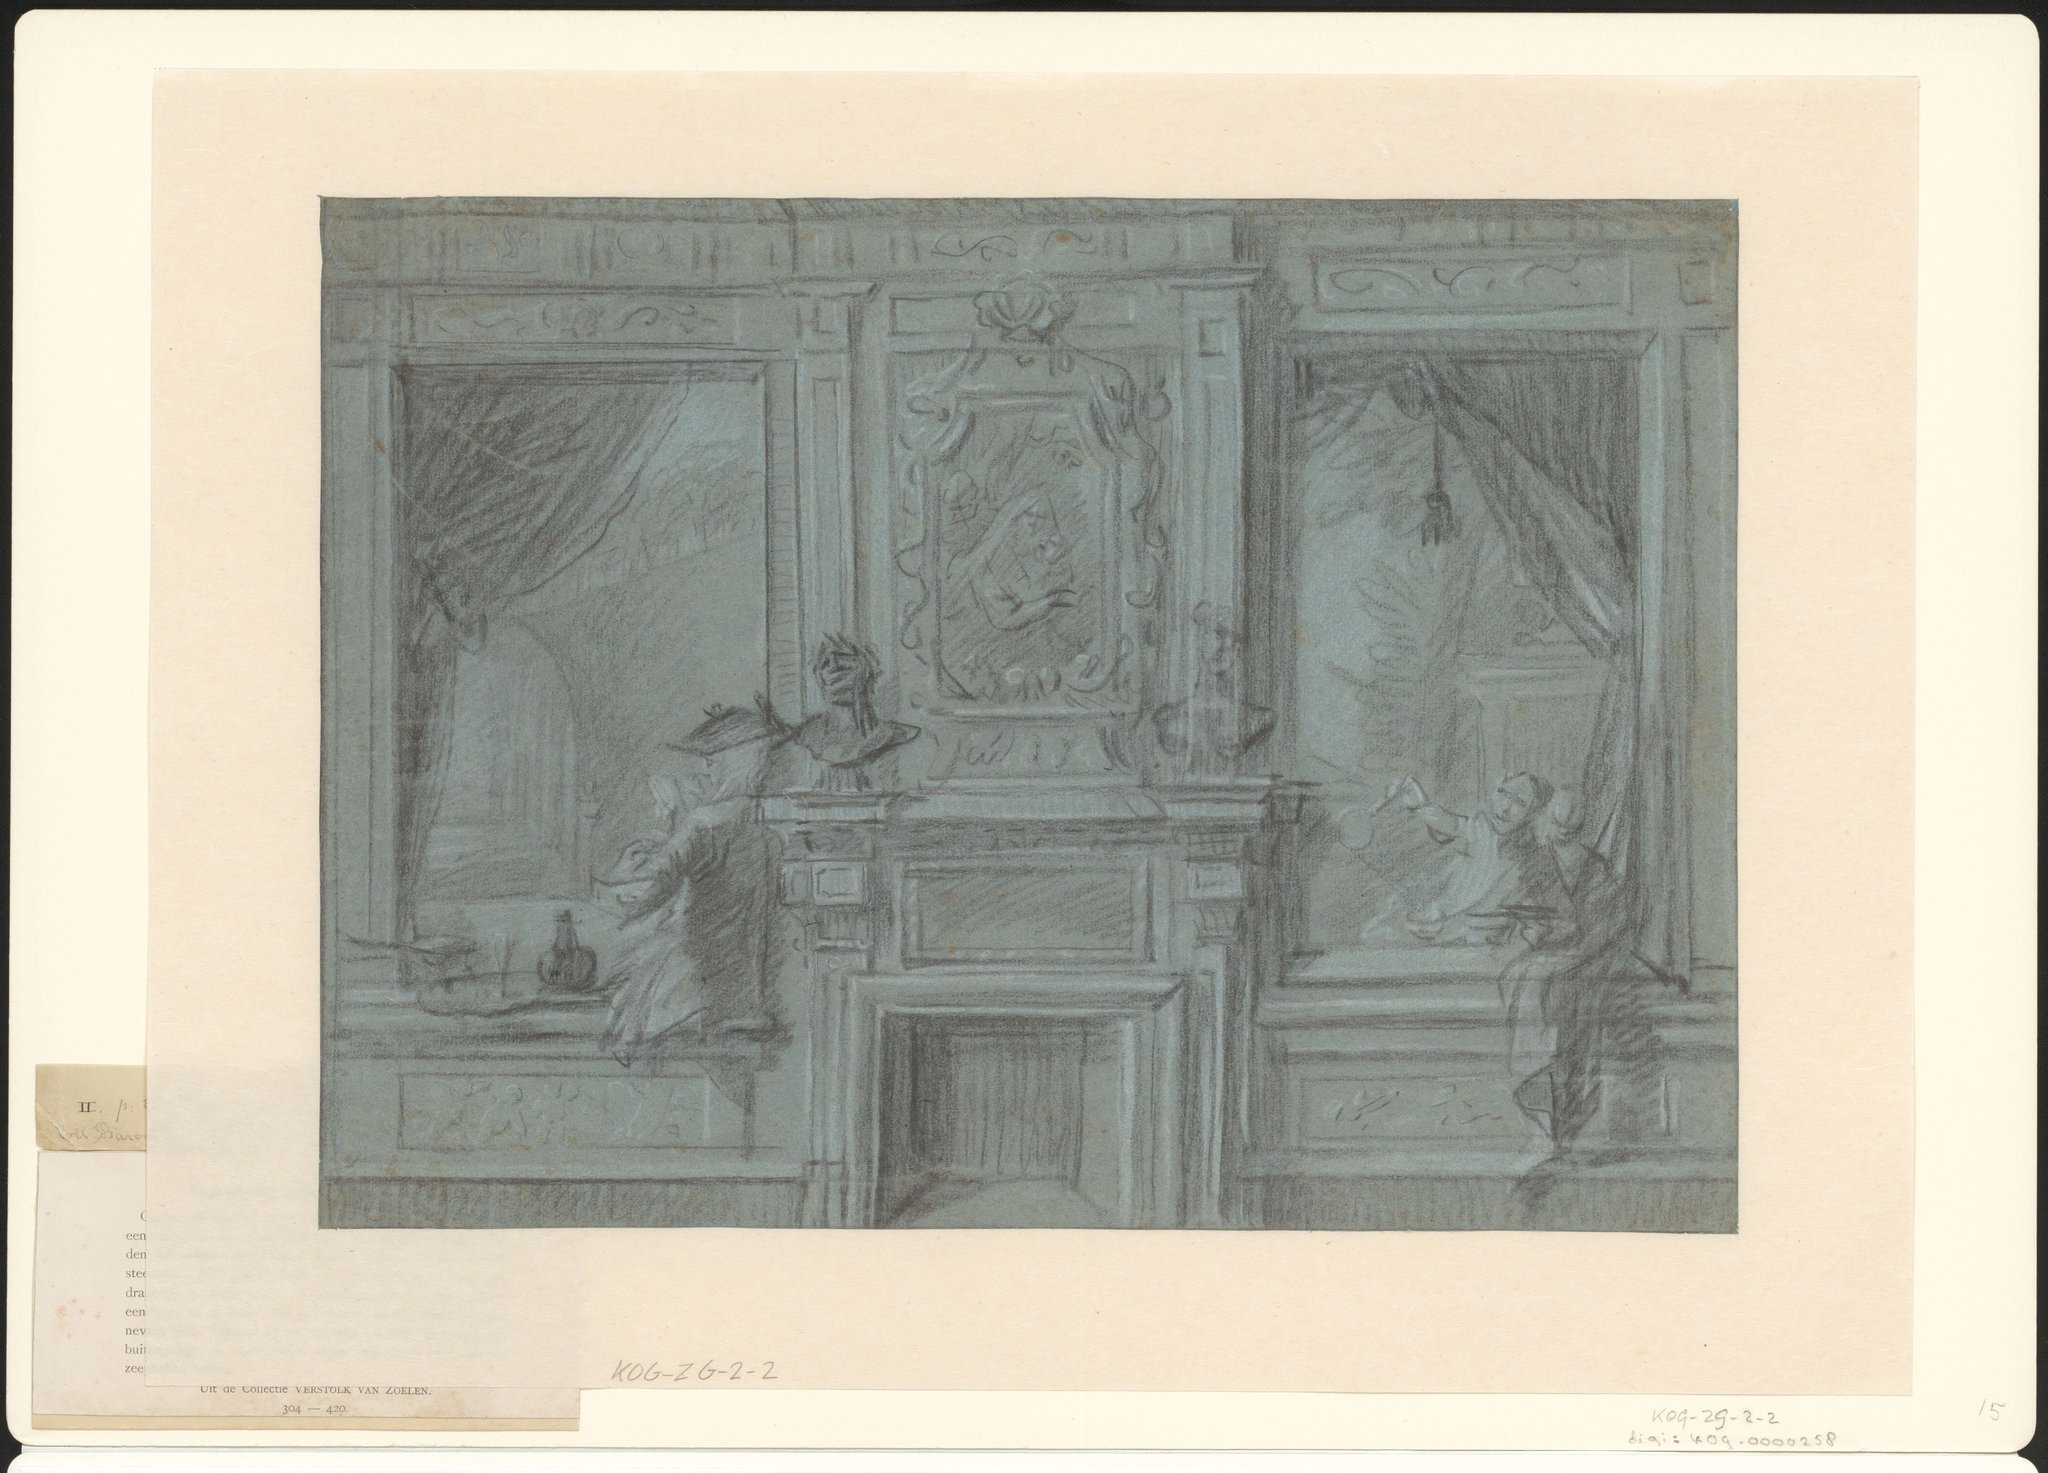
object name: design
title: Kamerwand met schoorsteenstuk en beschilderingen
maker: cornelis troost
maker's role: draughtsman, painter, print maker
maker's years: 1696-1750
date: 1712-1750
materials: chalk, paper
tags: communal rooms, chimney-piece, mantelpiece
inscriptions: collector's mark: Lugt 2488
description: Ontwerp voor een kamerwand met schoorsteenstuk en twee beschilderingen. Links een venster met zittende man, rechts bellenblazende kinderen.